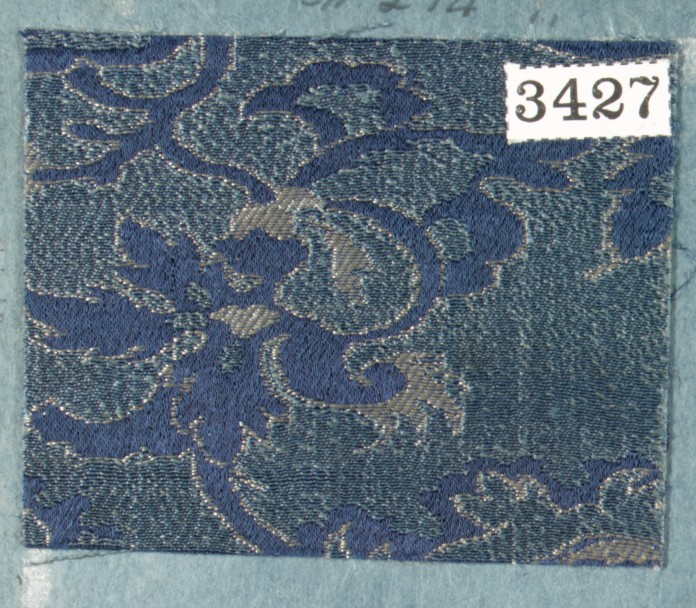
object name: textile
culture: japanese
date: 1801-1900